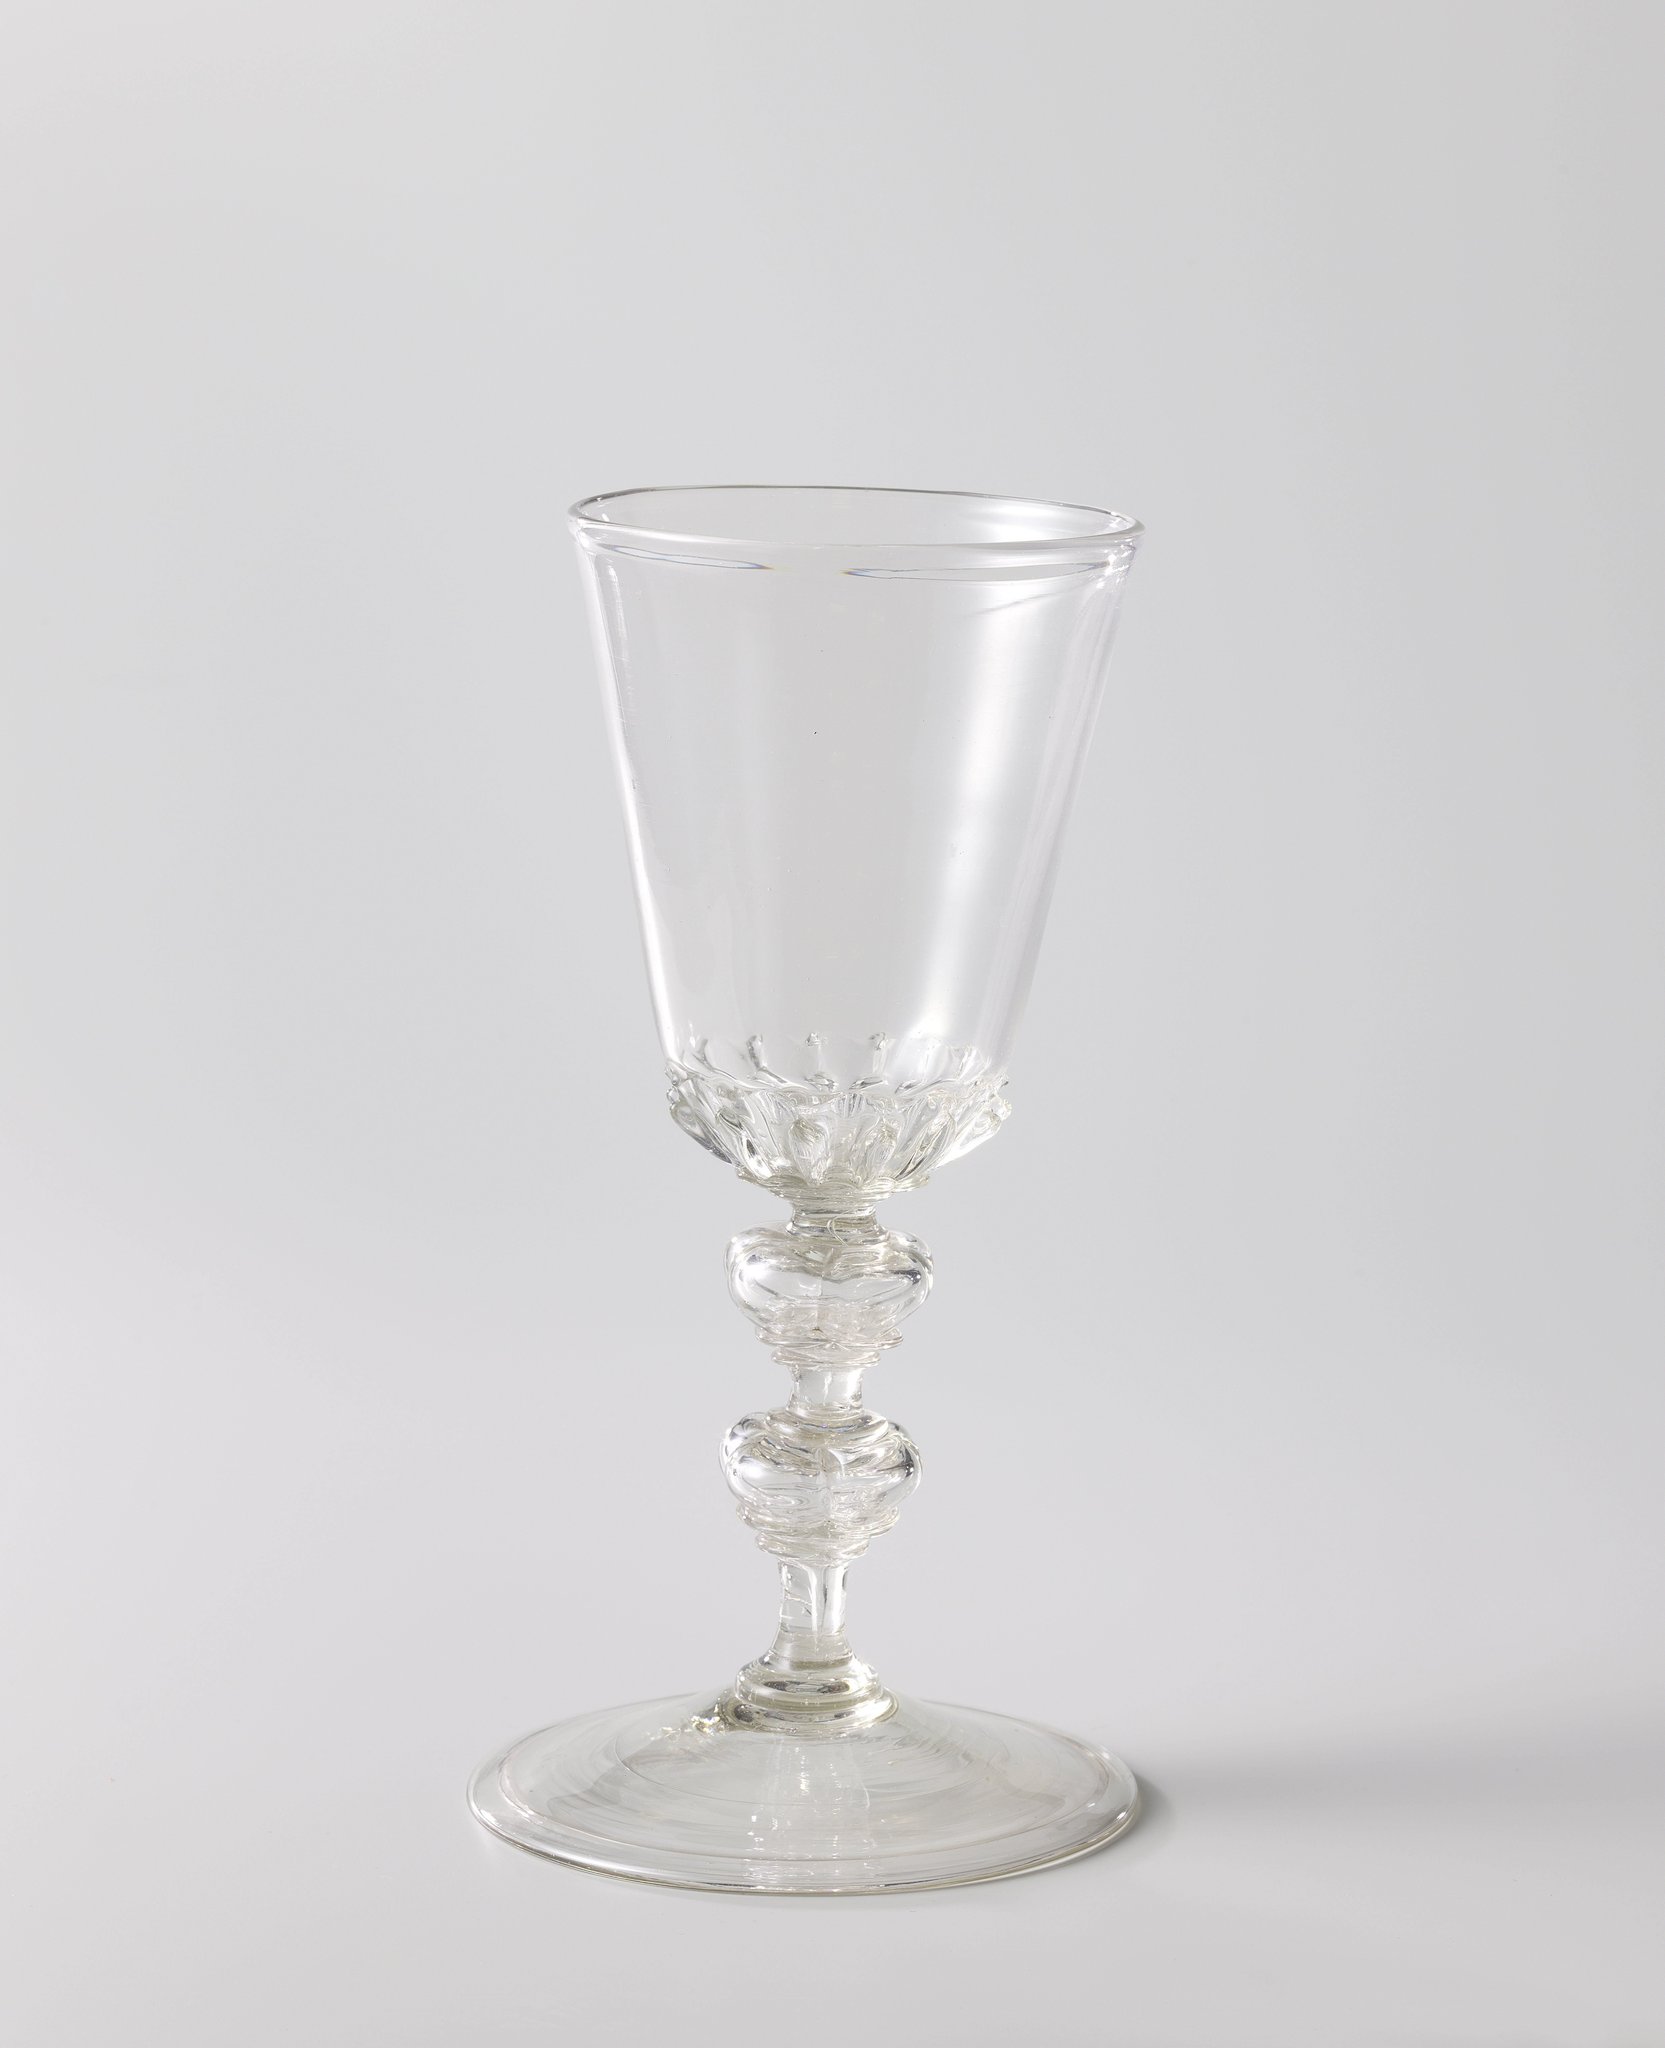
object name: goblet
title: Bokaal met een trechtervormige kelk en een stam met twee vierlobbige holle balusters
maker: Anonymous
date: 1600-1700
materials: glass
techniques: façon de venise, glassblowing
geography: low countries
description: Gewelfde voet met omgeslagen rand. De stam opgebouwd uit twee vierlobbige, holle balusters en drie schijven. Conische, aan de onderzijde afgeronde kelk, half in de vorm geblazen met ribben.